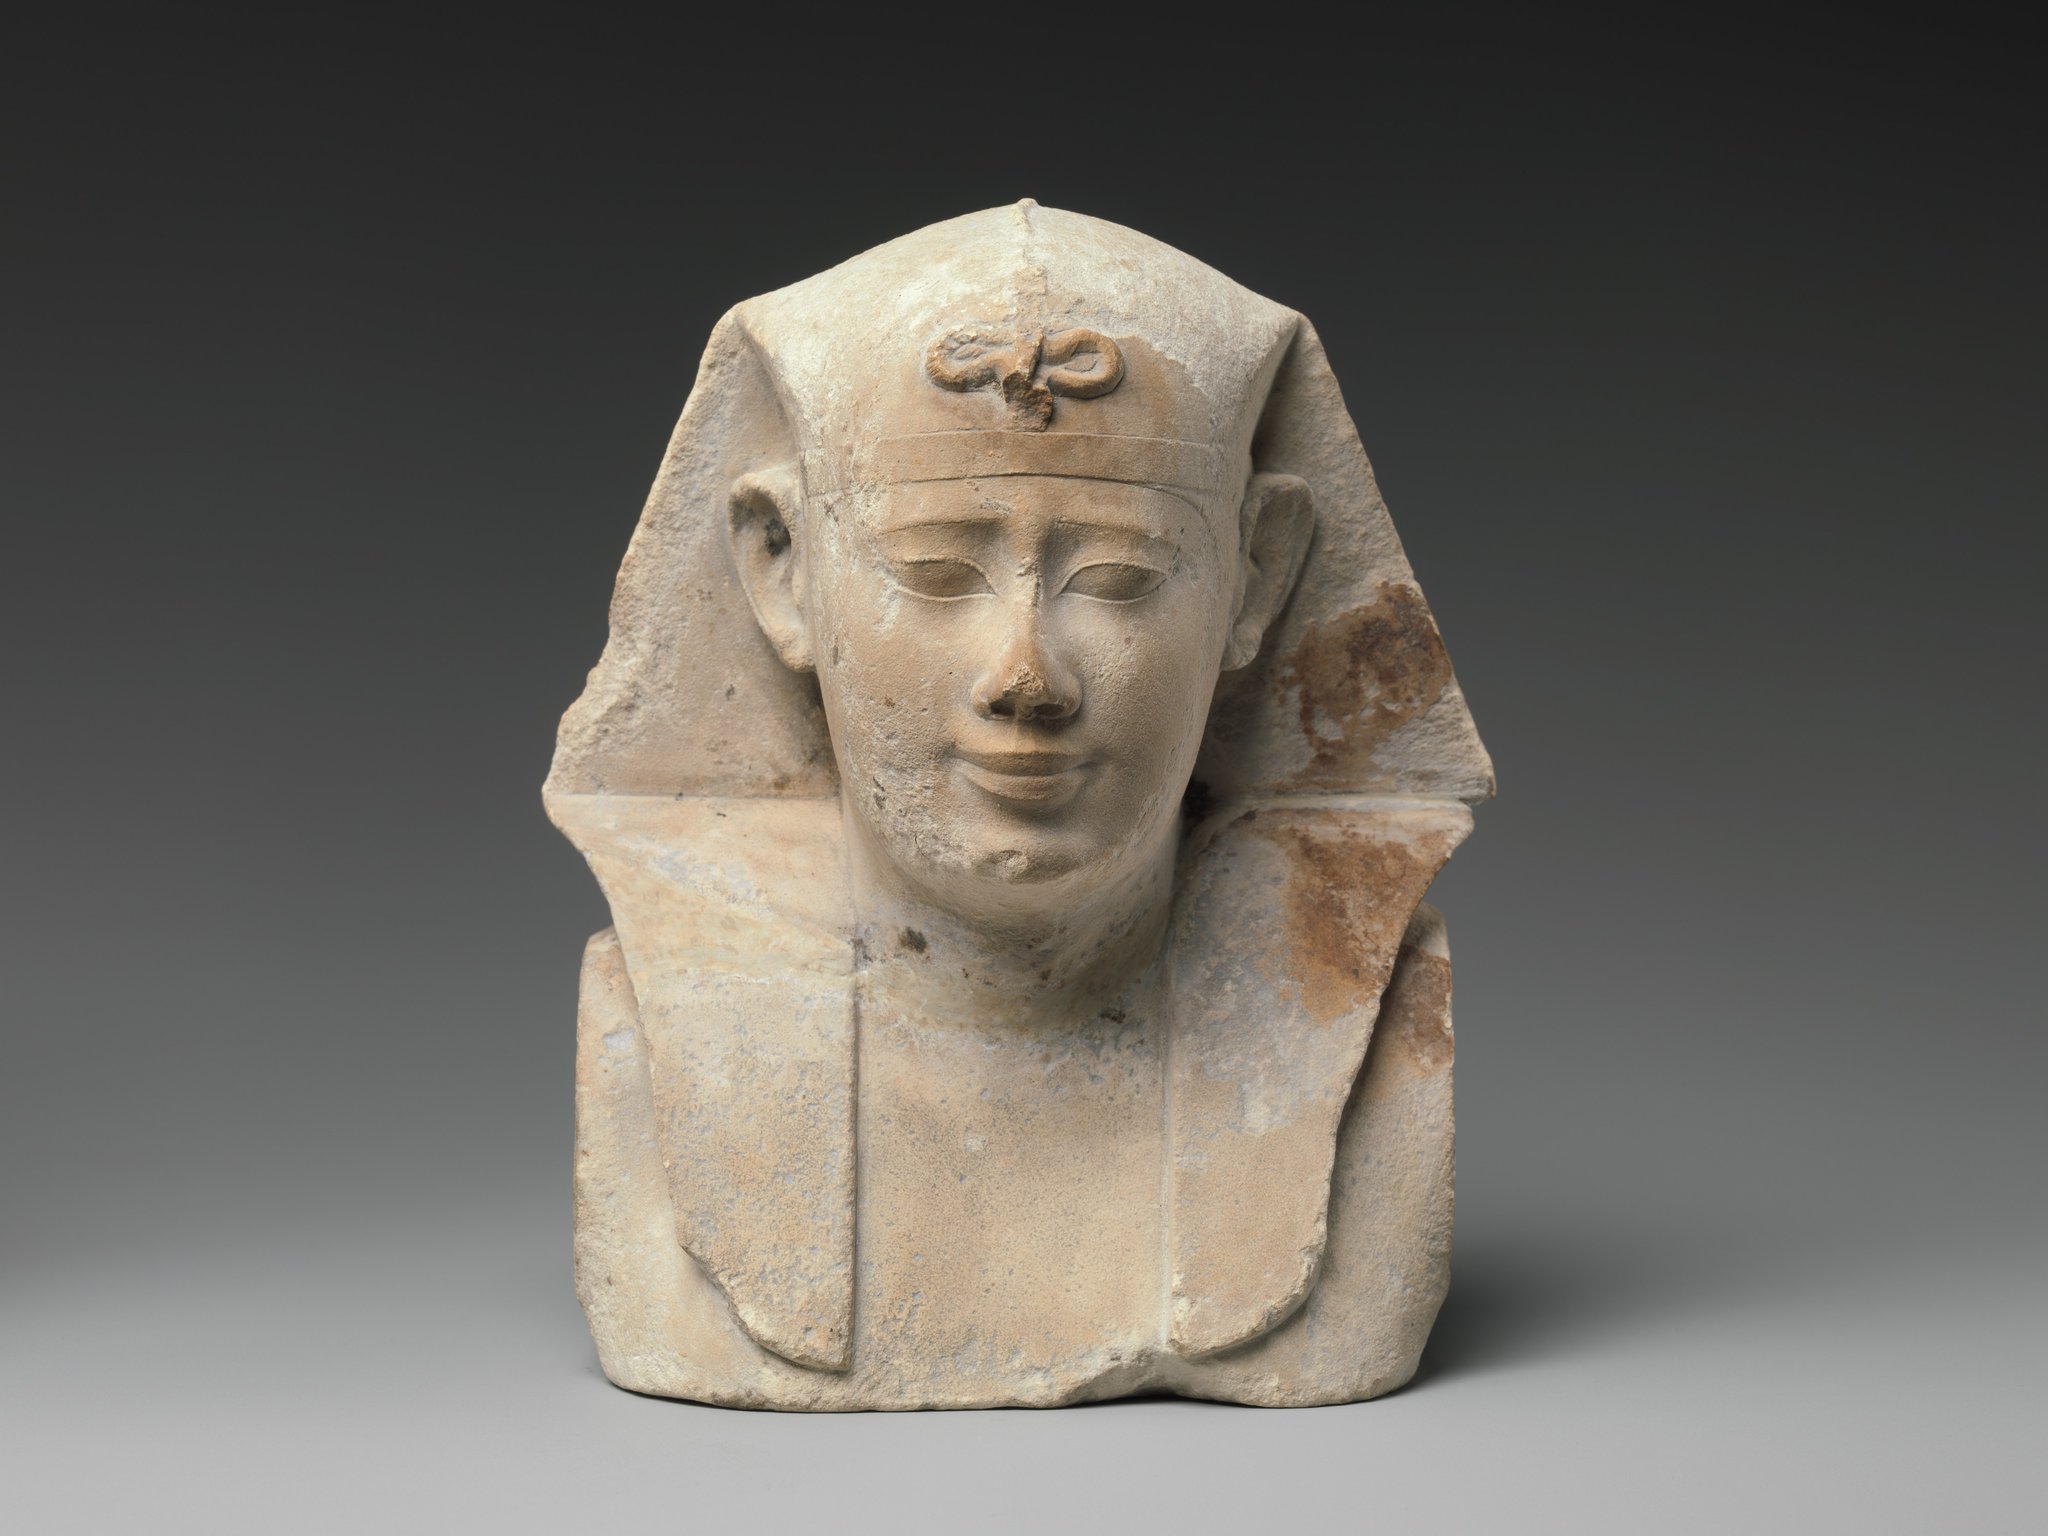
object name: sculptor's model votive, royal bust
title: Royal bust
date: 400-200 BCE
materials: limestone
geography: egypt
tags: human figures,heads